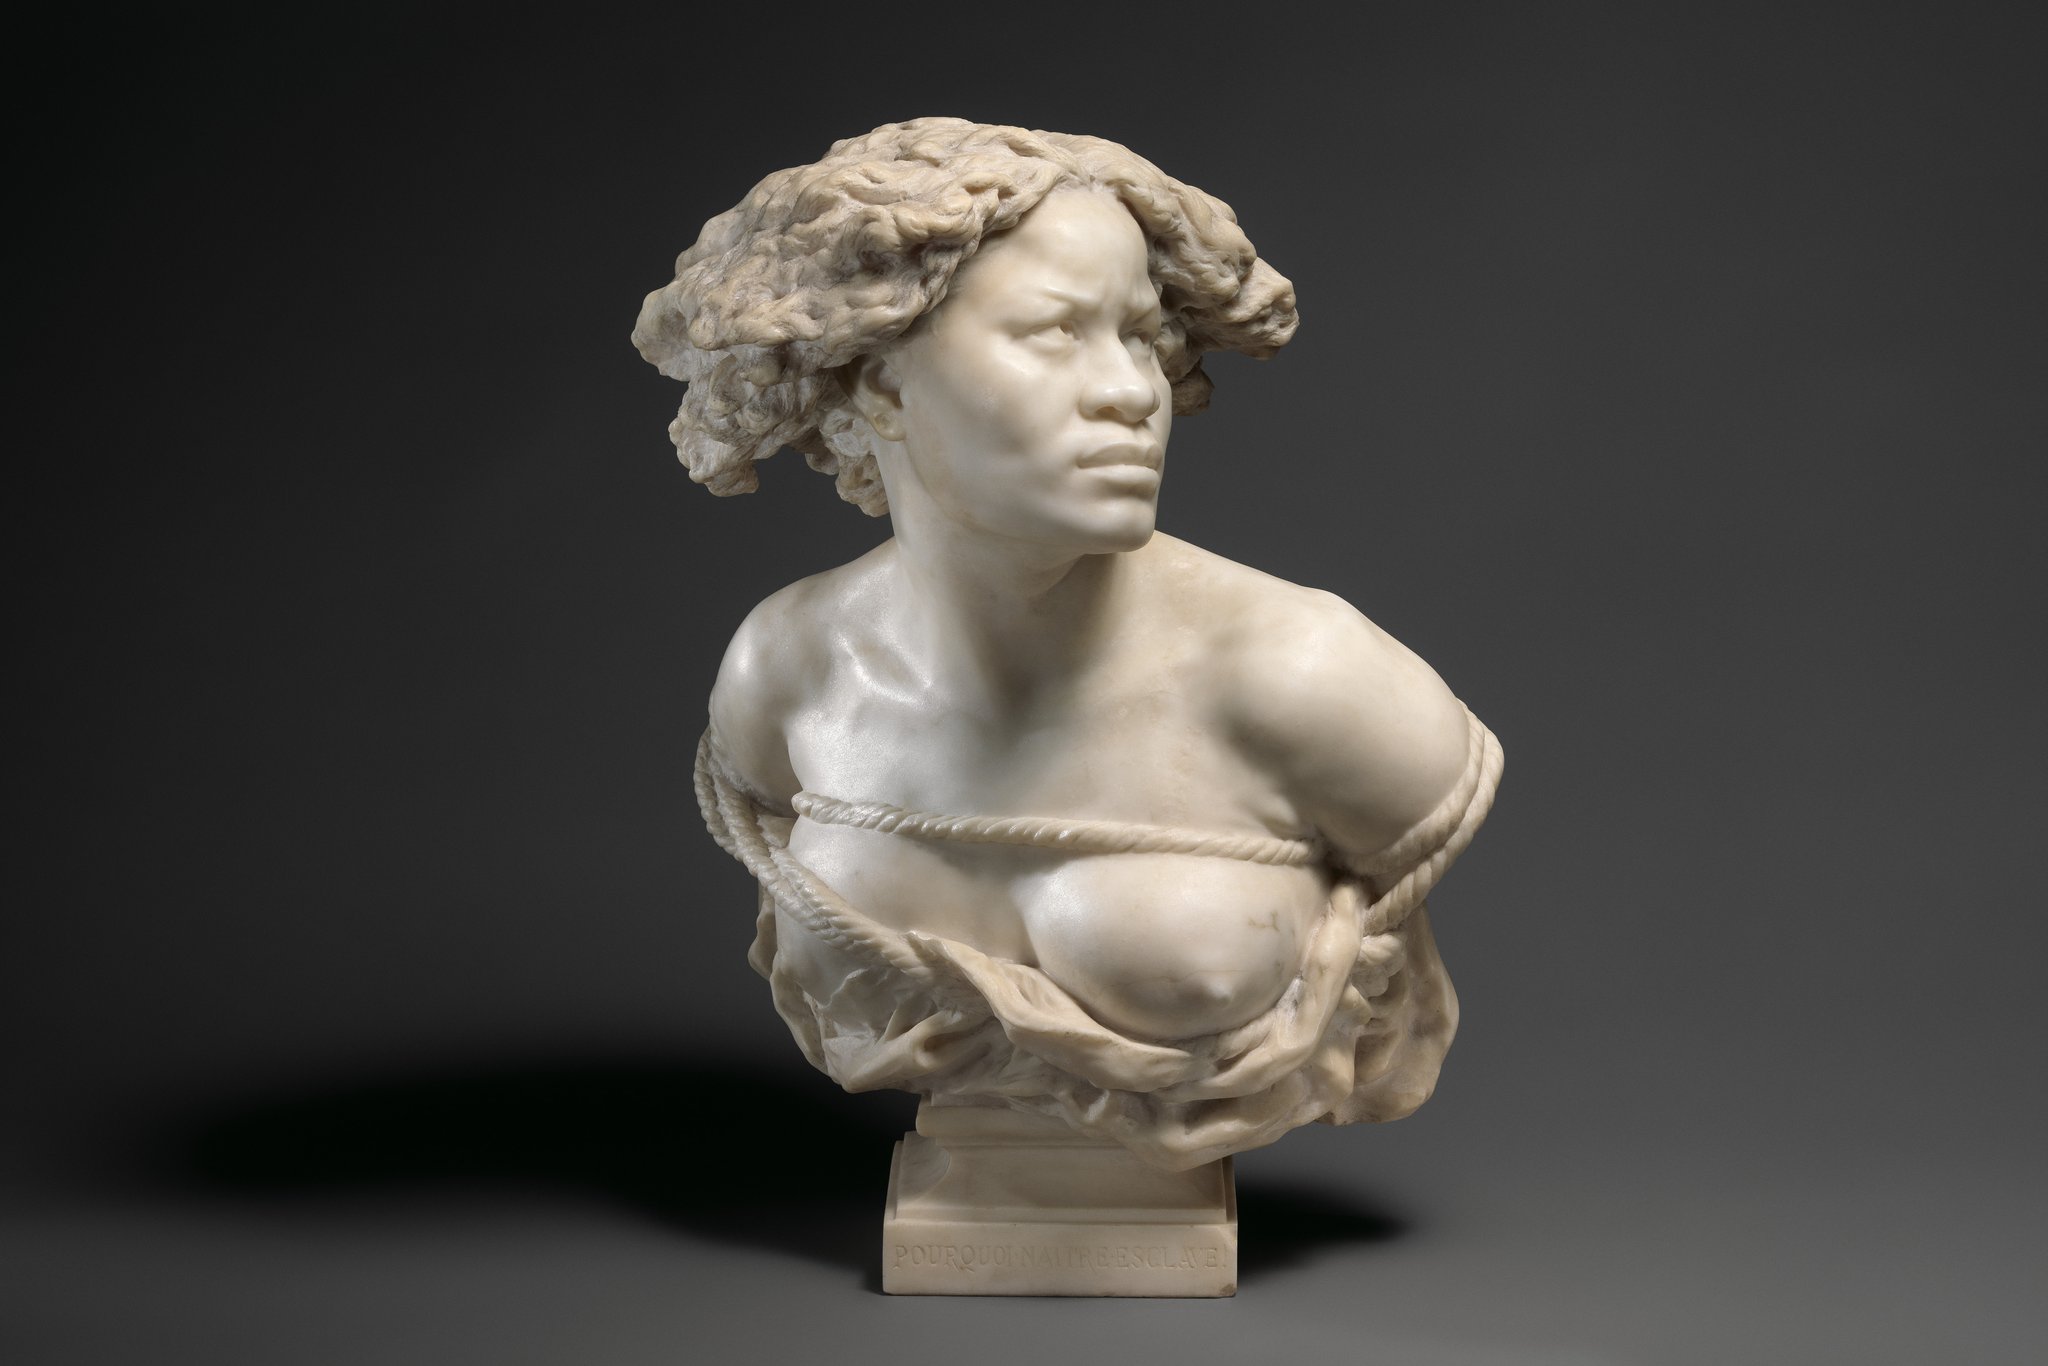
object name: bust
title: Why Born Enslaved!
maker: jean-baptiste carpeaux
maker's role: artist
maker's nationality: french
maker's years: 1827-1875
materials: marble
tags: women,female nudes,slaves